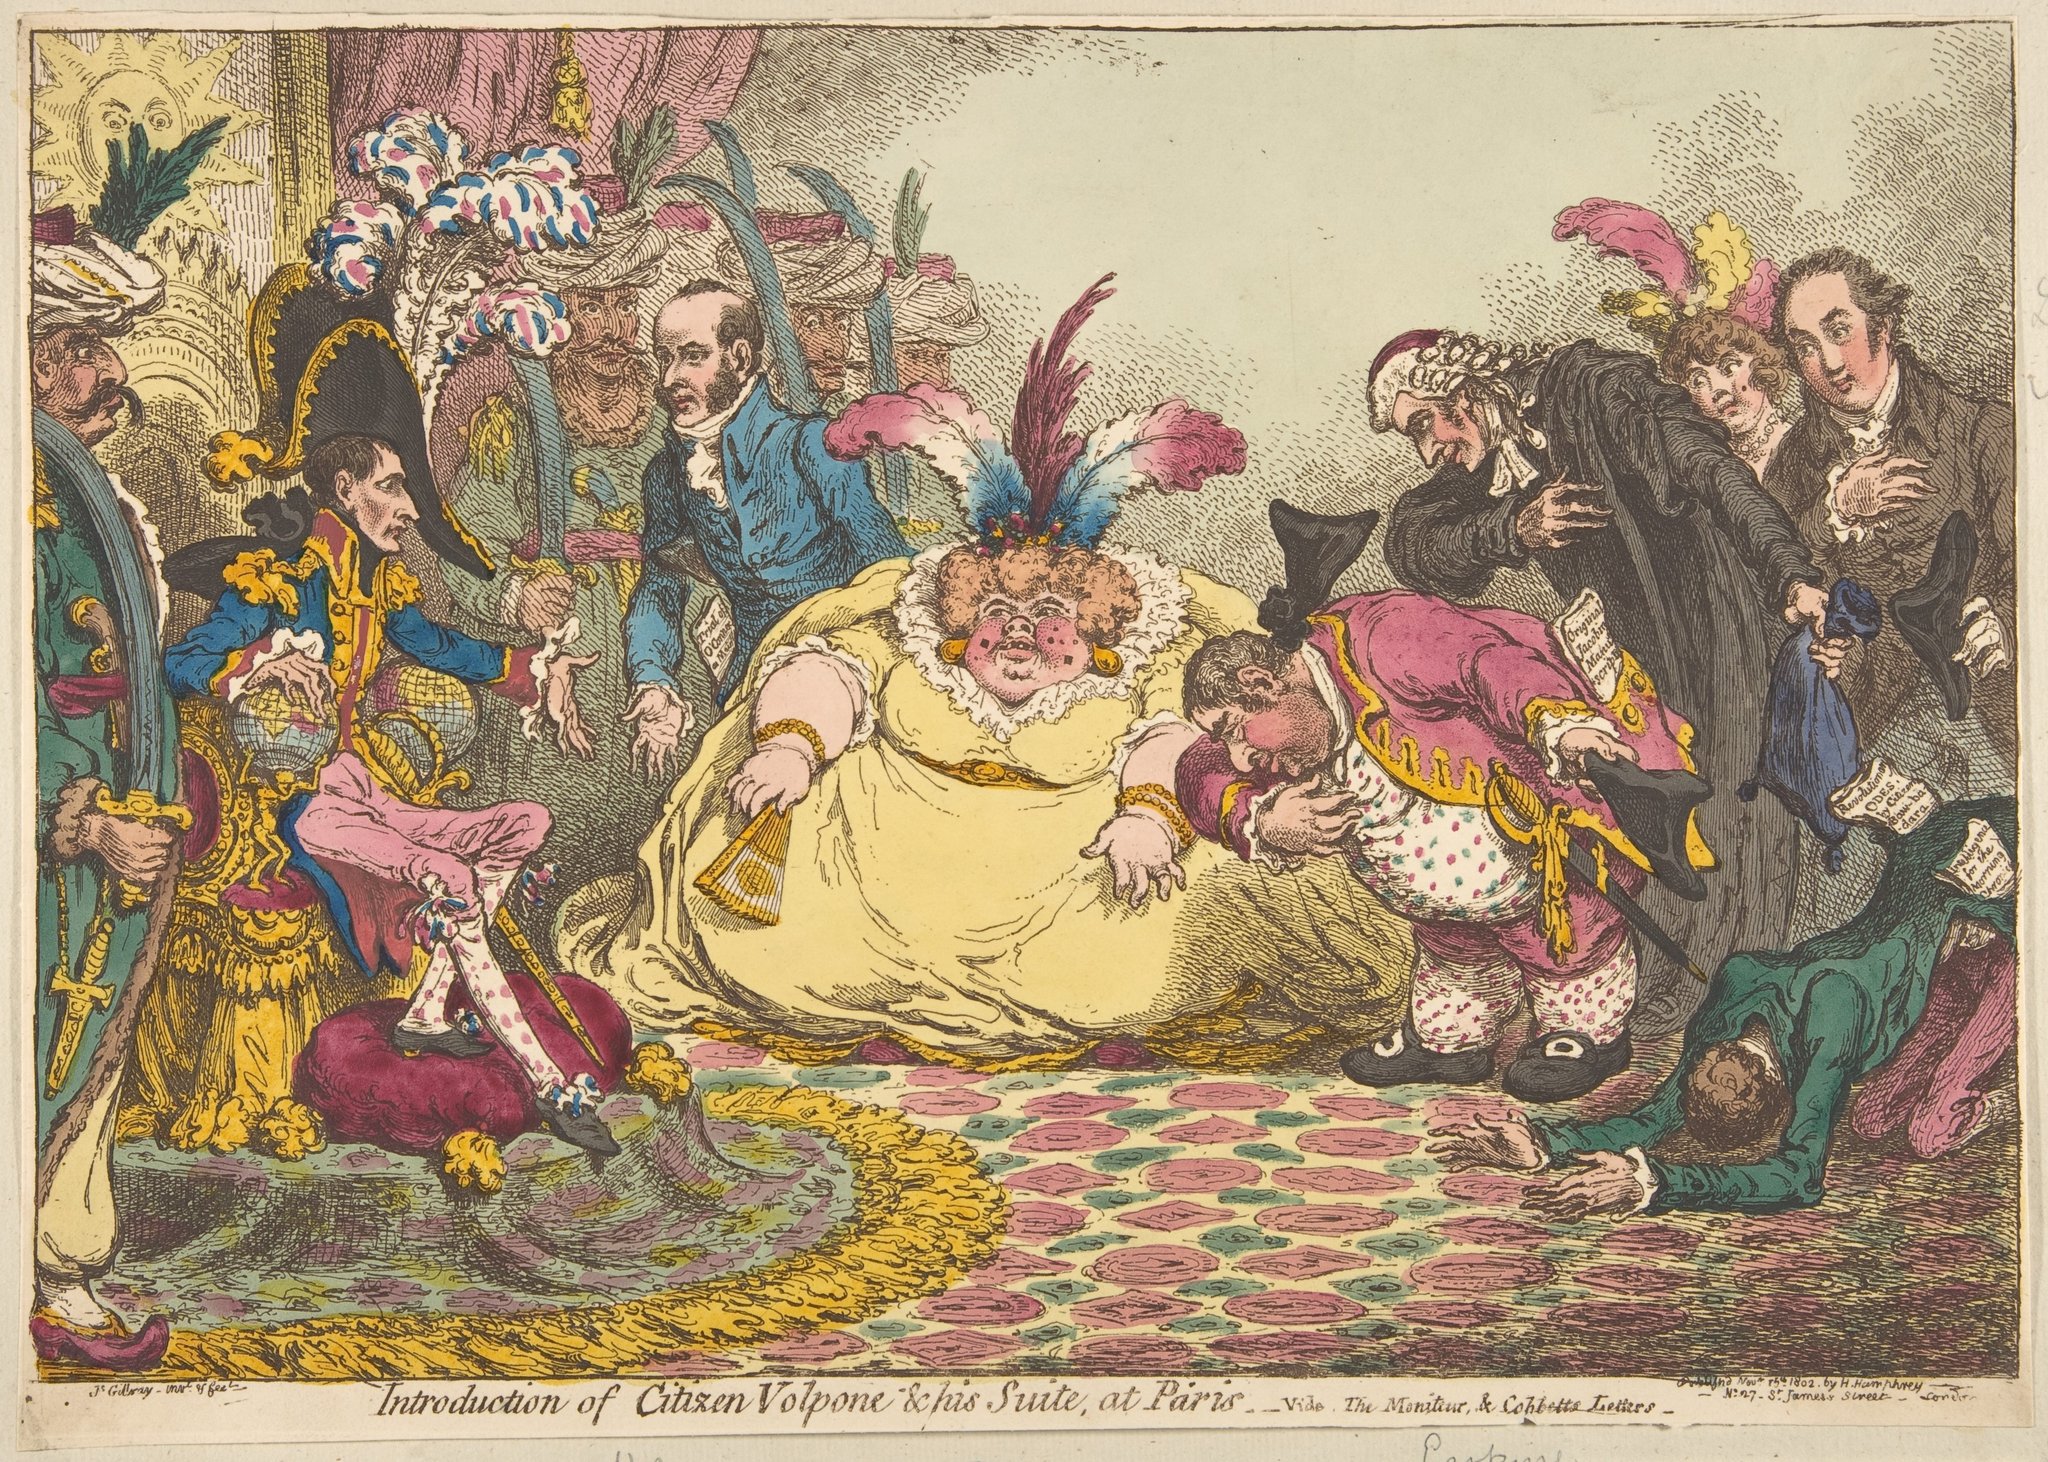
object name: print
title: Introduction of Citizen Volpone & His Suite, at Paris.–Vide, The Moniteur, & Cobbetts Letters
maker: james gillray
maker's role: artist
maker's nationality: british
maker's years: 1756-1815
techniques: etching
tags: satire,napoleon i,men,women,politics